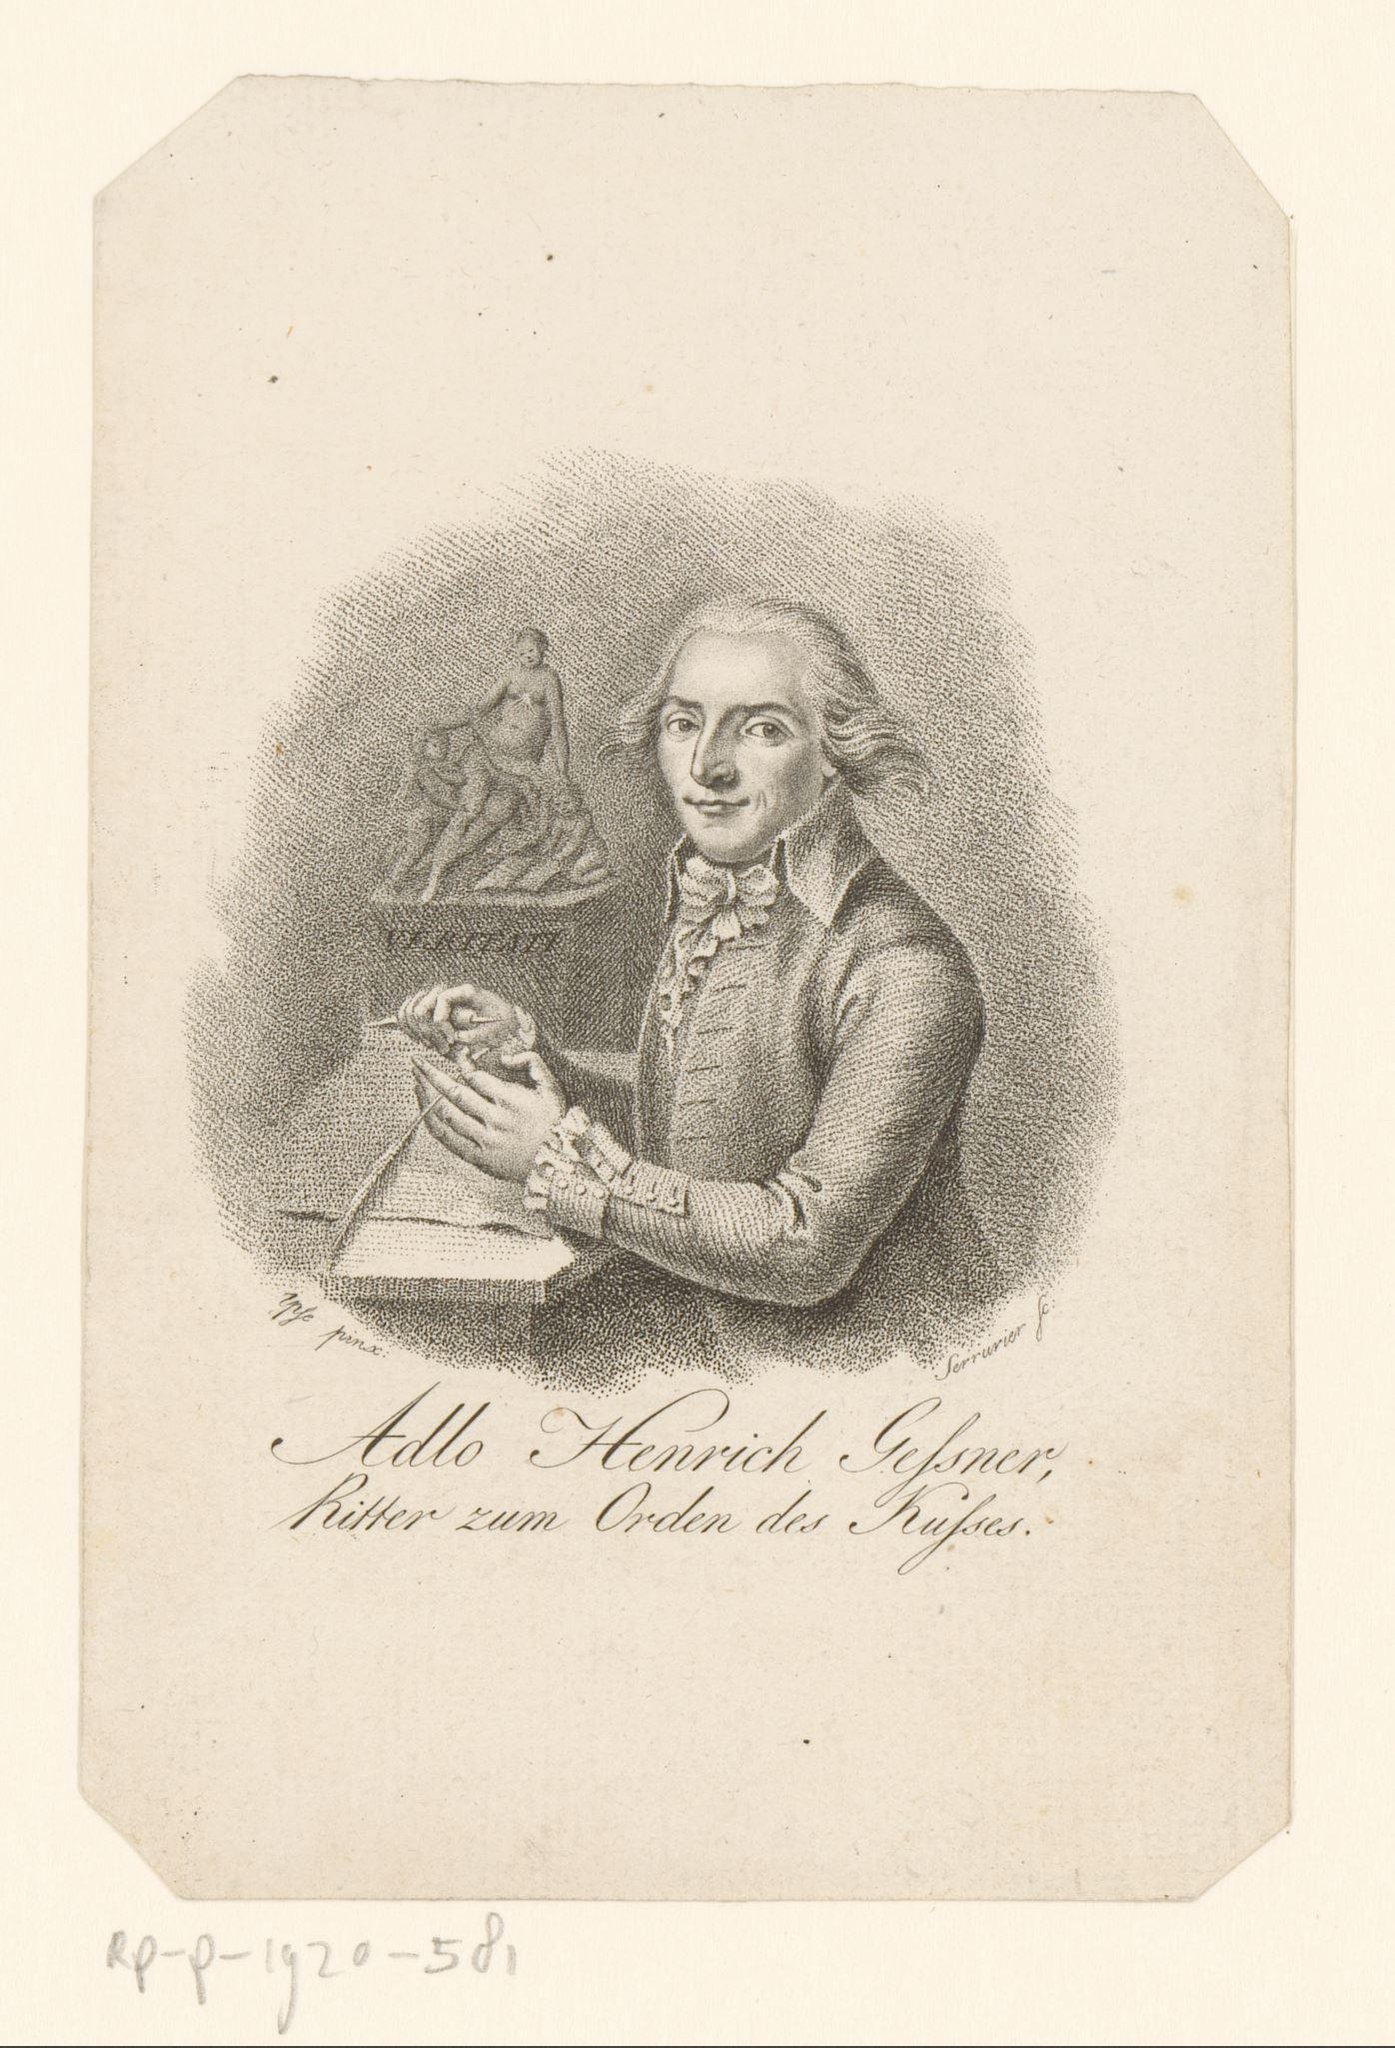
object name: print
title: Portret van Adolph Heinrich Meltzer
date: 1781-1799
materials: paper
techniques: engraving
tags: adolph heinrich meltzer, historical persons, writing accessories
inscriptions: collector's mark: Lugt 2228